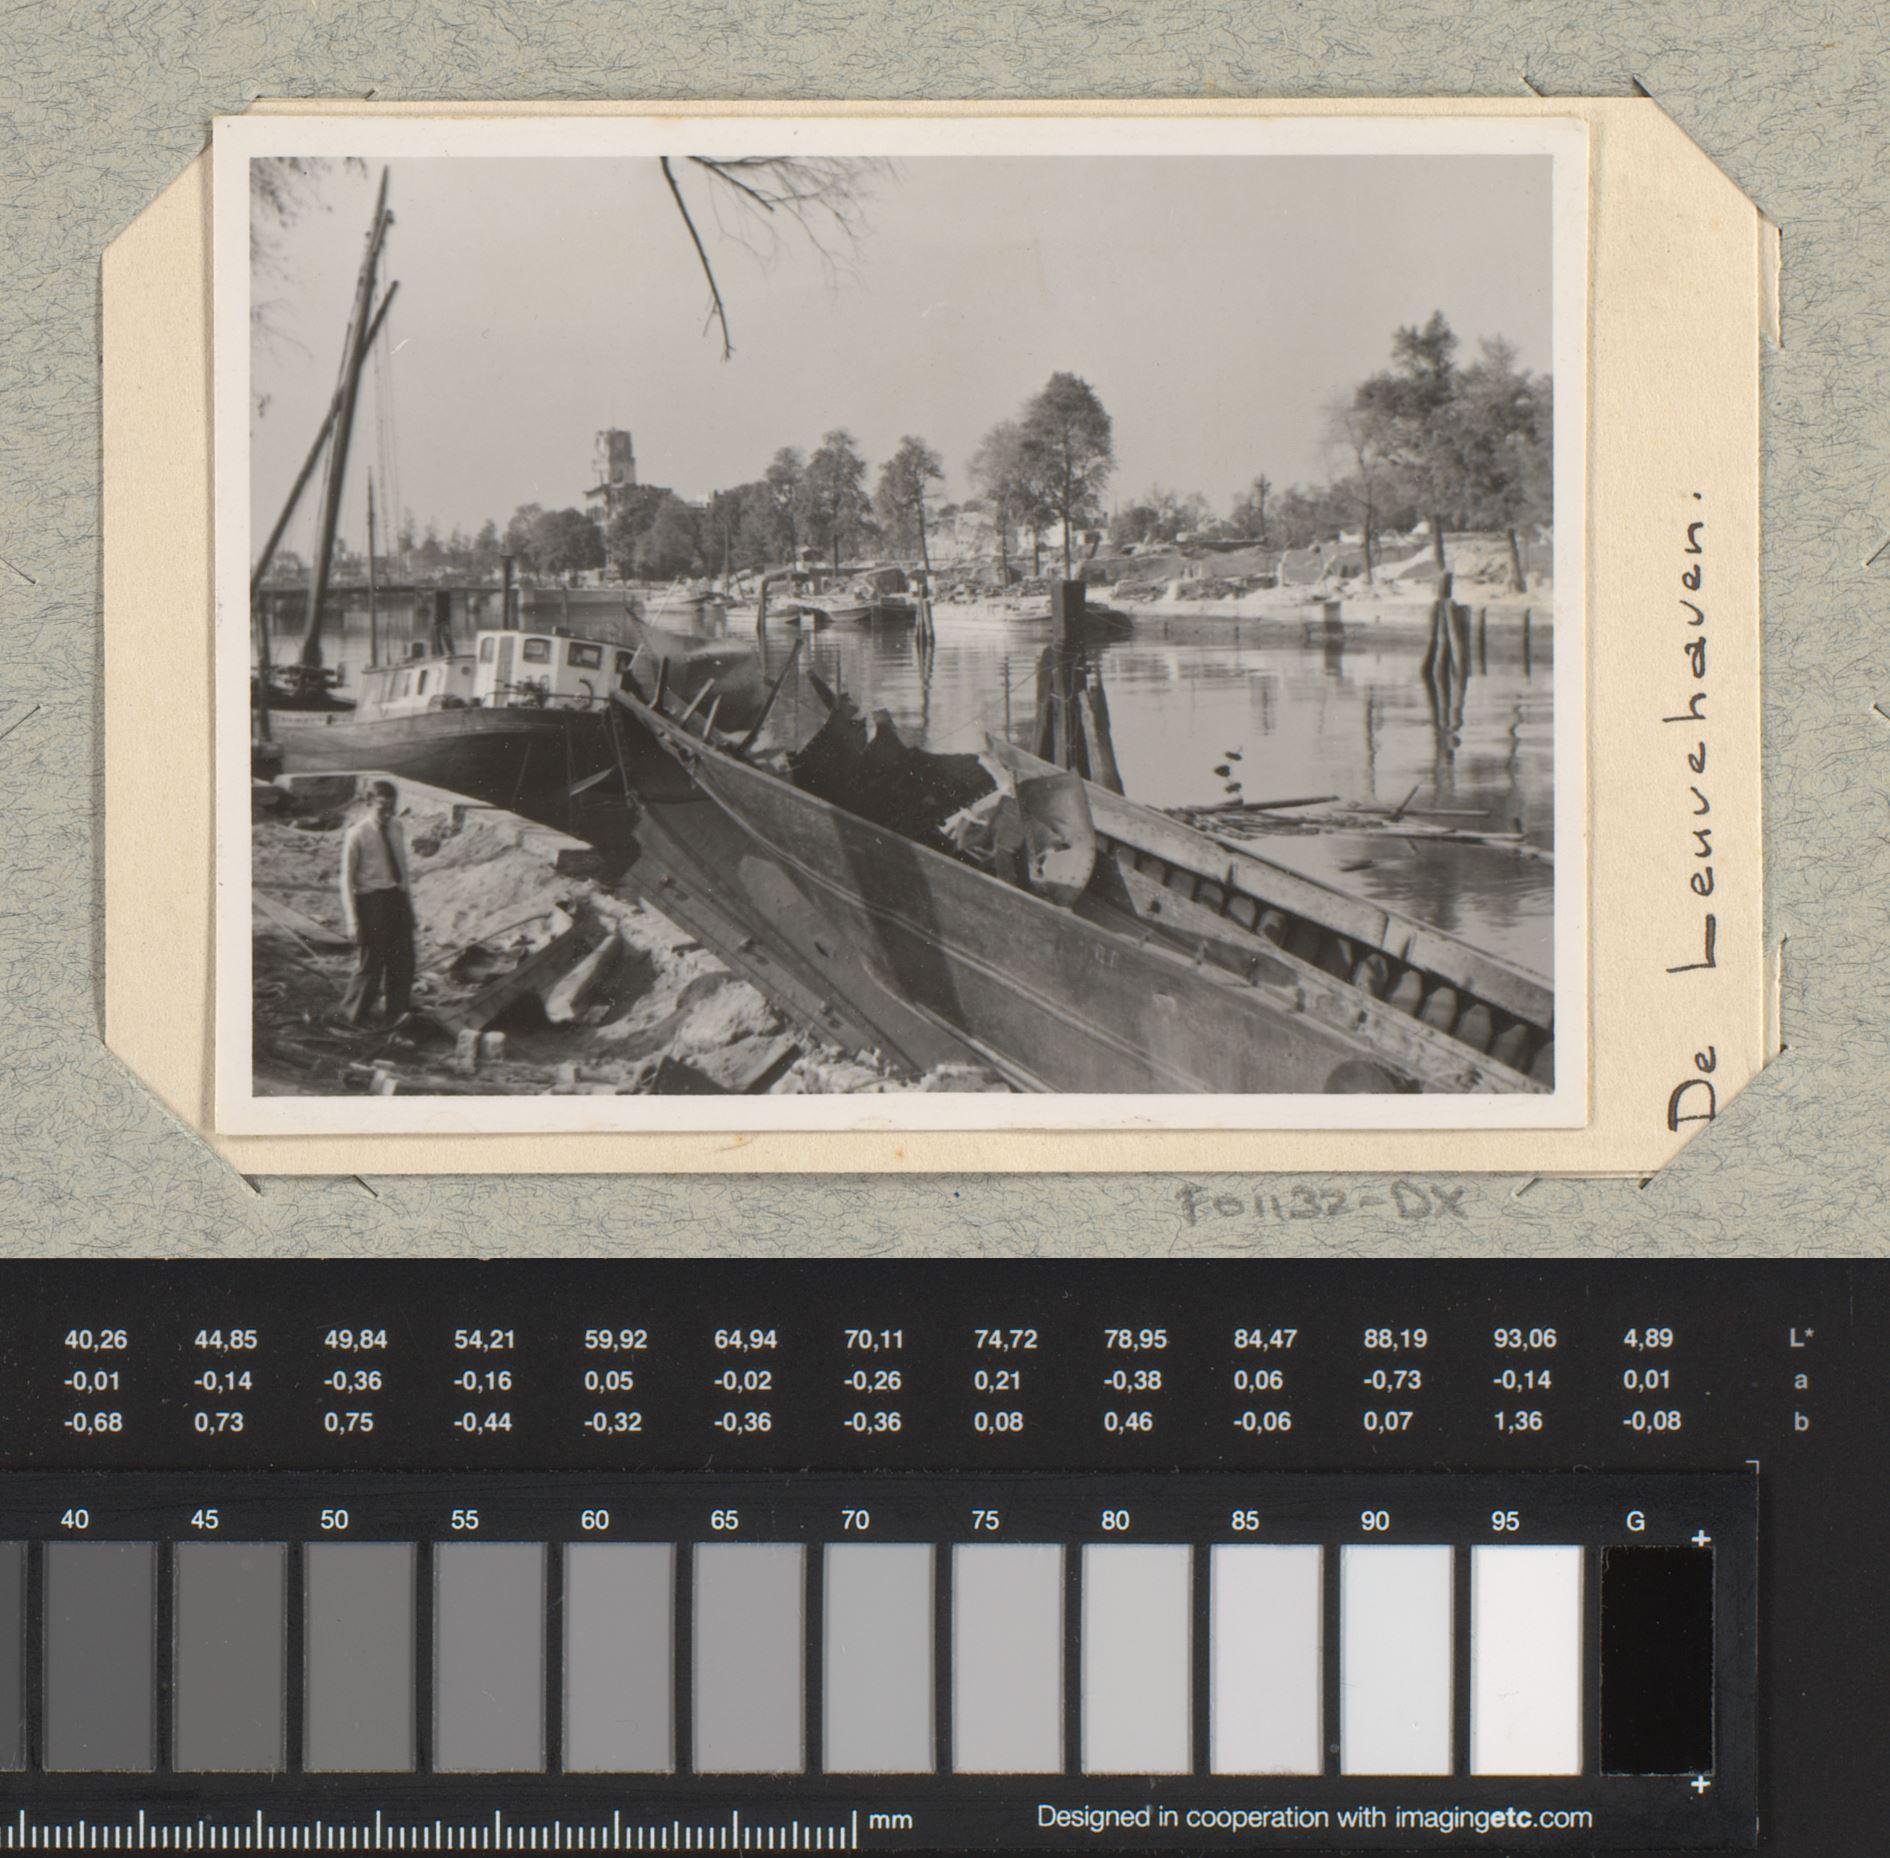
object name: photograph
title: Ruïnes rondom de Leuvehaven te Rotterdam met schepen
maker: j. nolte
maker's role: fotograaf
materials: photographic support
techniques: gelatin silver print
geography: rotterdam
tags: ships (in general), devastated, ruined place or city (~ warfare), rotterdam, rotterdam blitz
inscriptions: annotation: ‘De Leuvehaven’